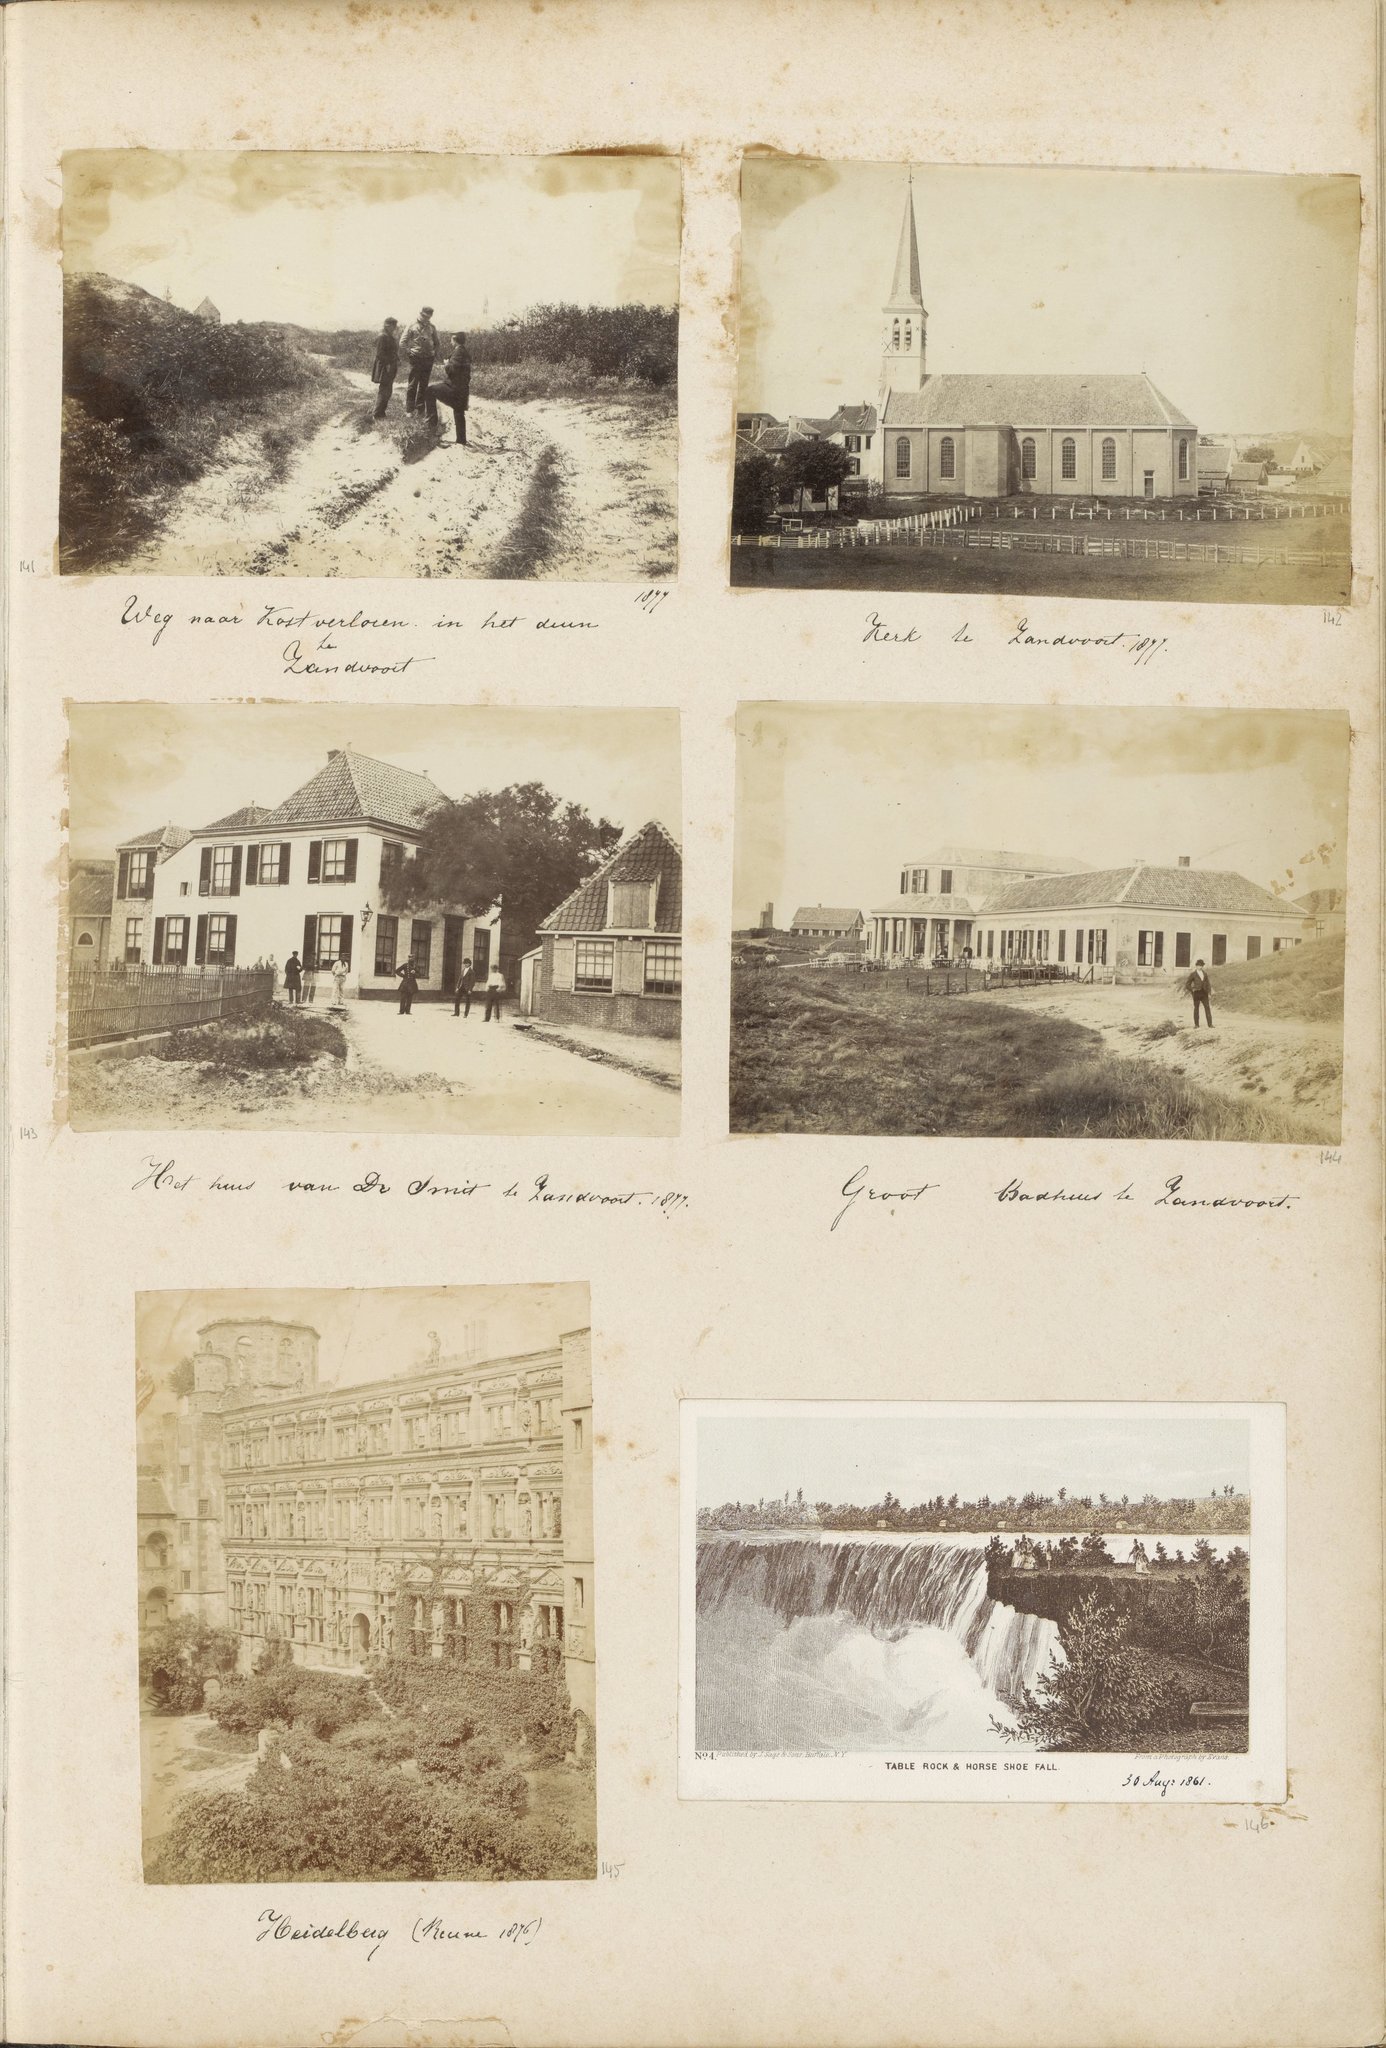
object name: photograph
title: Groep mensen poserend voor het huis van dokter Smit te Zandvoort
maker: Anonymous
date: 1877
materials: paper, photographic support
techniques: albumen print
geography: zandvoort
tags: rural housing, e.g. country-house, villa, cottage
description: Onderdeel van Fotoalbum van Robert Daniel Crommelin (1841-1907).